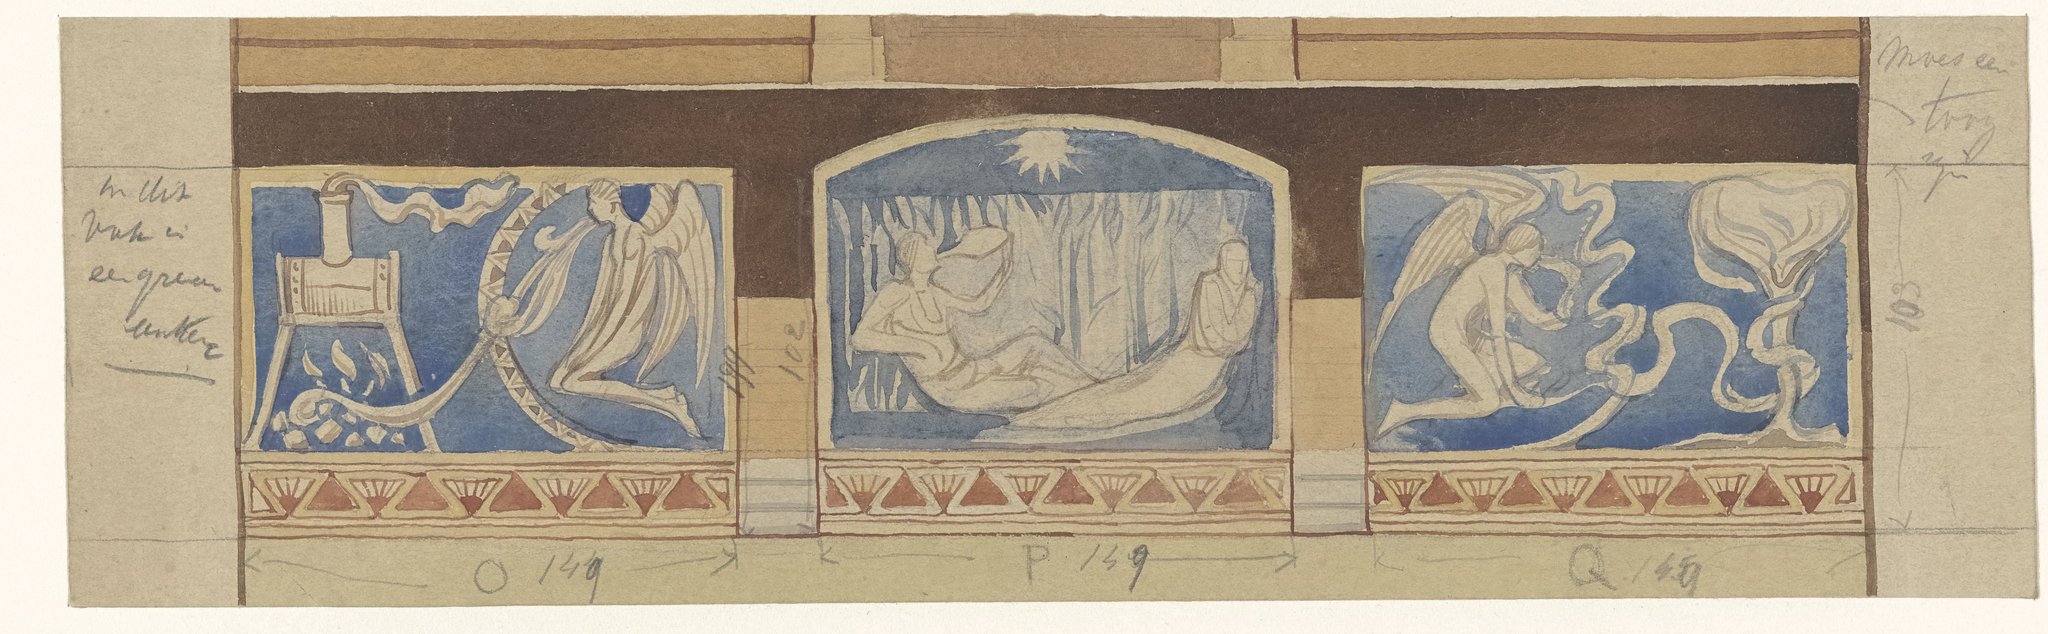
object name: design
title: Vuur als vriend en vijand en seizoen Zomer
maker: antoon derkinderen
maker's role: draughtsman, painter, print maker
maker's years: 1859-1925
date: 1869-1925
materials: paper, pencil, watercolor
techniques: brush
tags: fire (one of the four elements), summer ~ human activities (the four seasons of the year)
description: Ontwerp voor de wandschildering in het gebouw van de Algemeene Maatschappij van Levensverzekering en Lijfrente te Amsterdam: Vuur als vriend en vijand en seizoen Zomer.